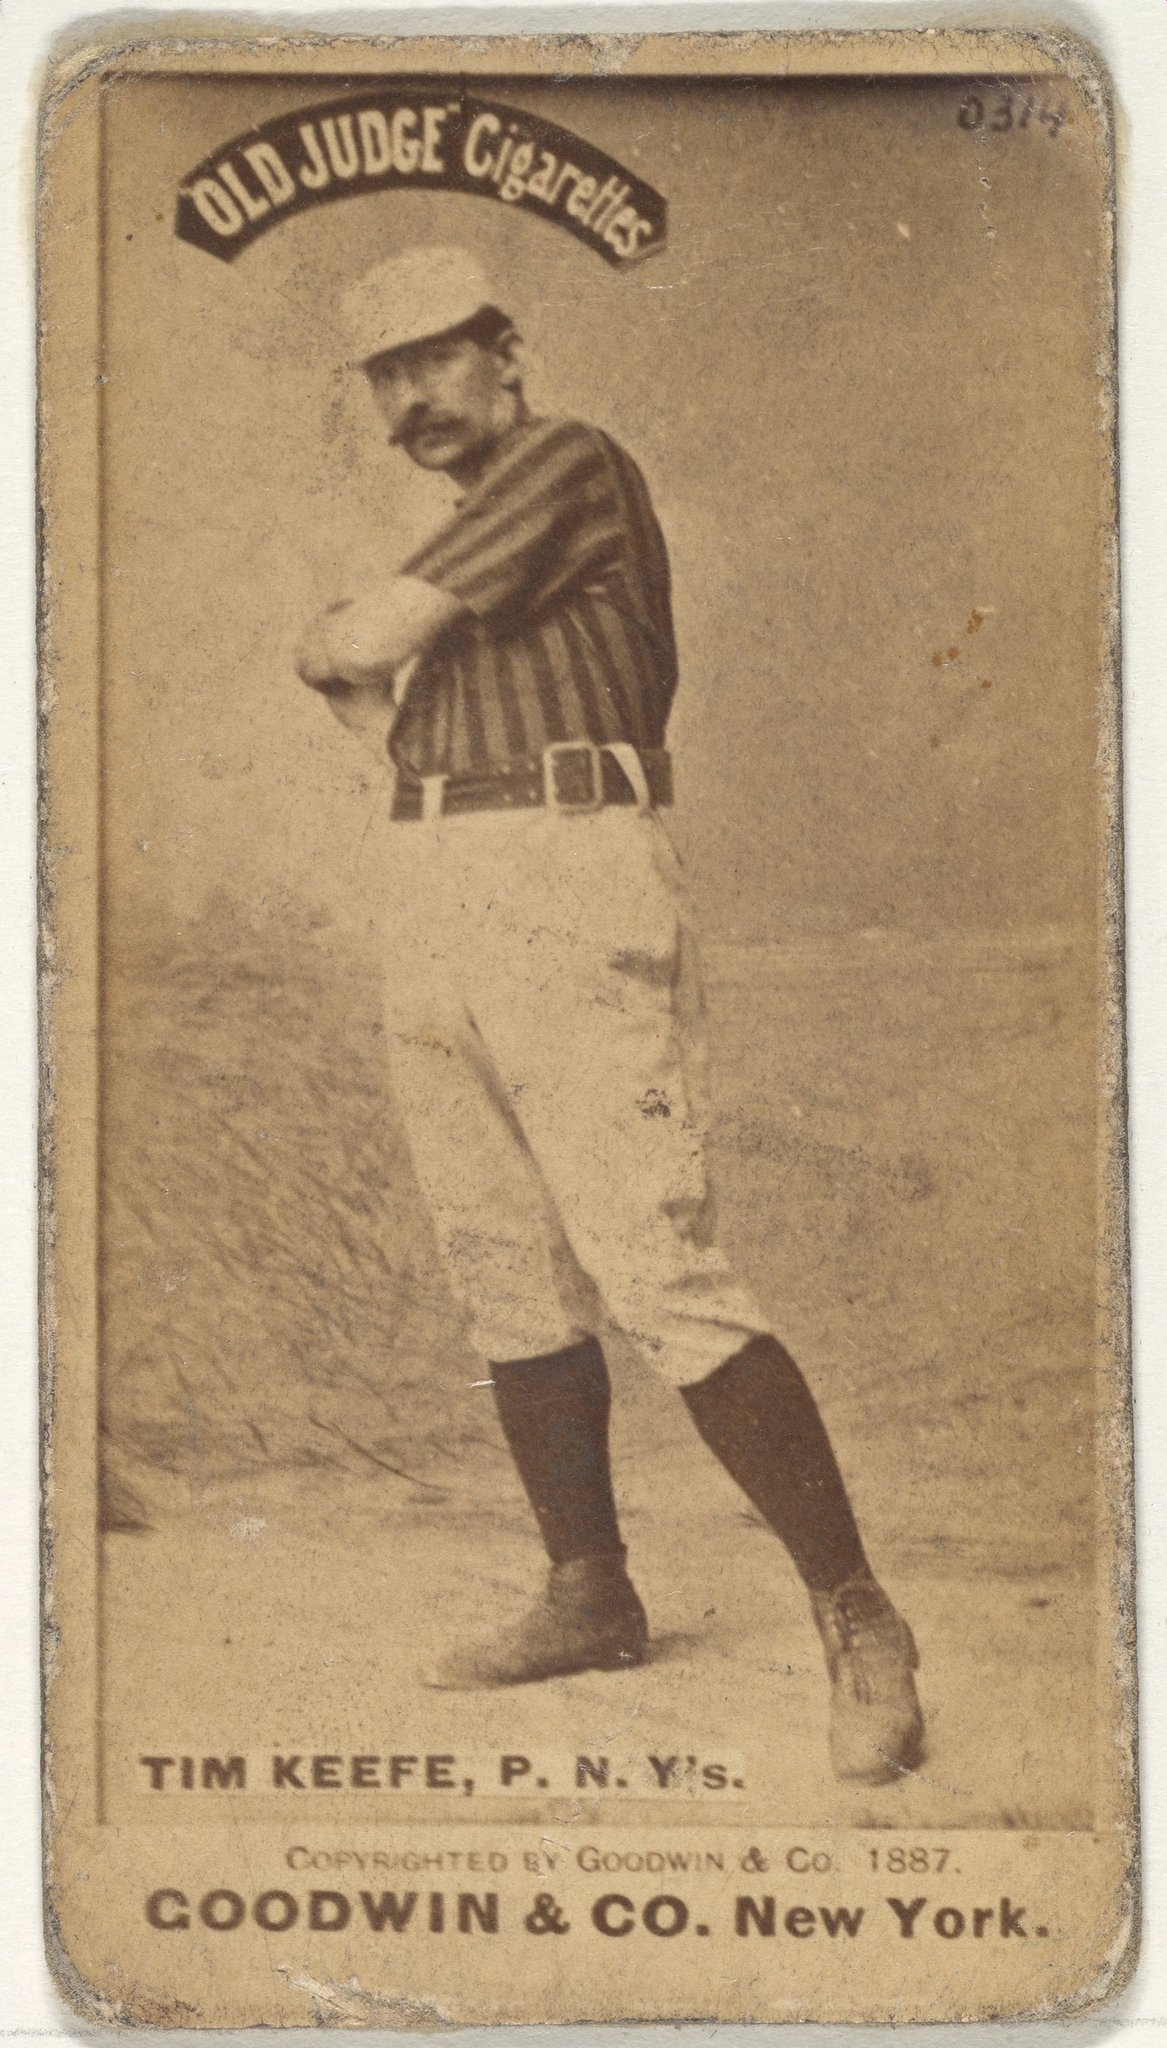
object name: baseball card, photograph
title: Timothy John "Tim" Keefe, Pitcher, New York, from the Old Judge series (N172) for Old Judge Cigarettes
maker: goodwin & company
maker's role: publisher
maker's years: 1850-1950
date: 1887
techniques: albumen silver print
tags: men,portraits,baseball,athletes